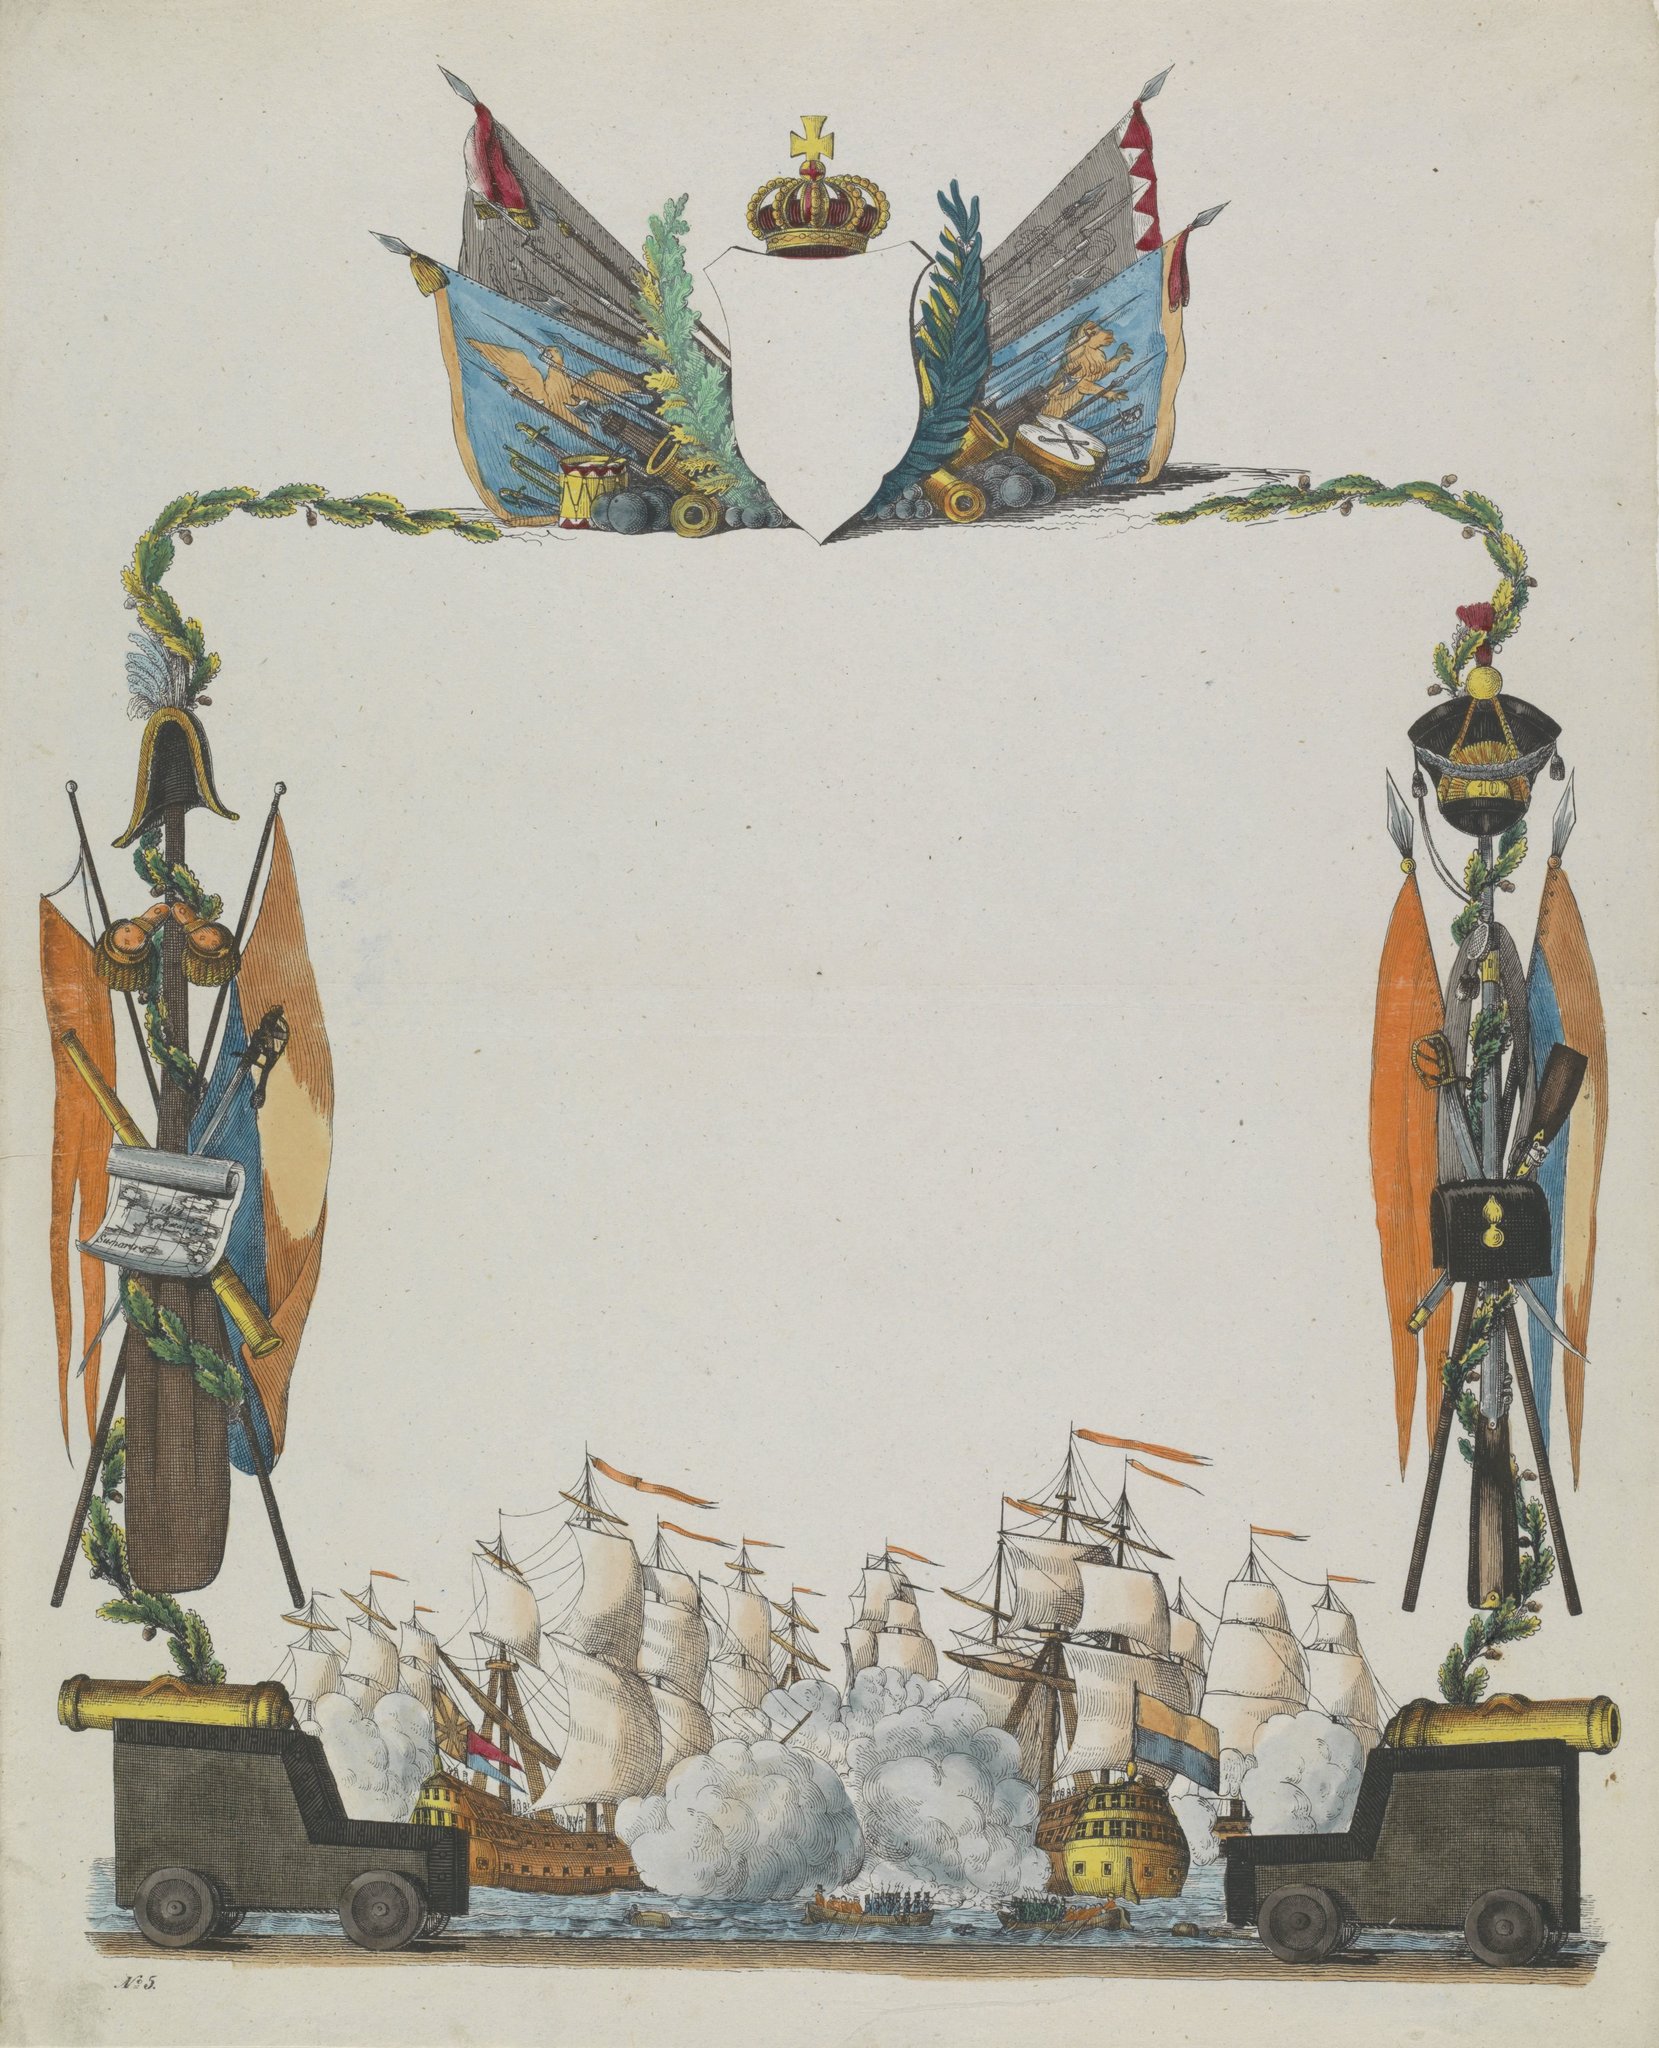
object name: wensbrief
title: Wensbrief met een zeeslag, kanonnen en vlaggen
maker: Anonymous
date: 1780-1899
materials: paper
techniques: colour, lithograph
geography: netherlands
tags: military vehicles (+ sailing-ships), firearms: cannon, (military) flags and standards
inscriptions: collector's mark: Lugt 2760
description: Wensbrief met onbeschreven cartouche binnen een decoratief kader met voorstellingen van een zeeslag, kanonnen en vlaggen. Genummerd linksonder: No. 5.